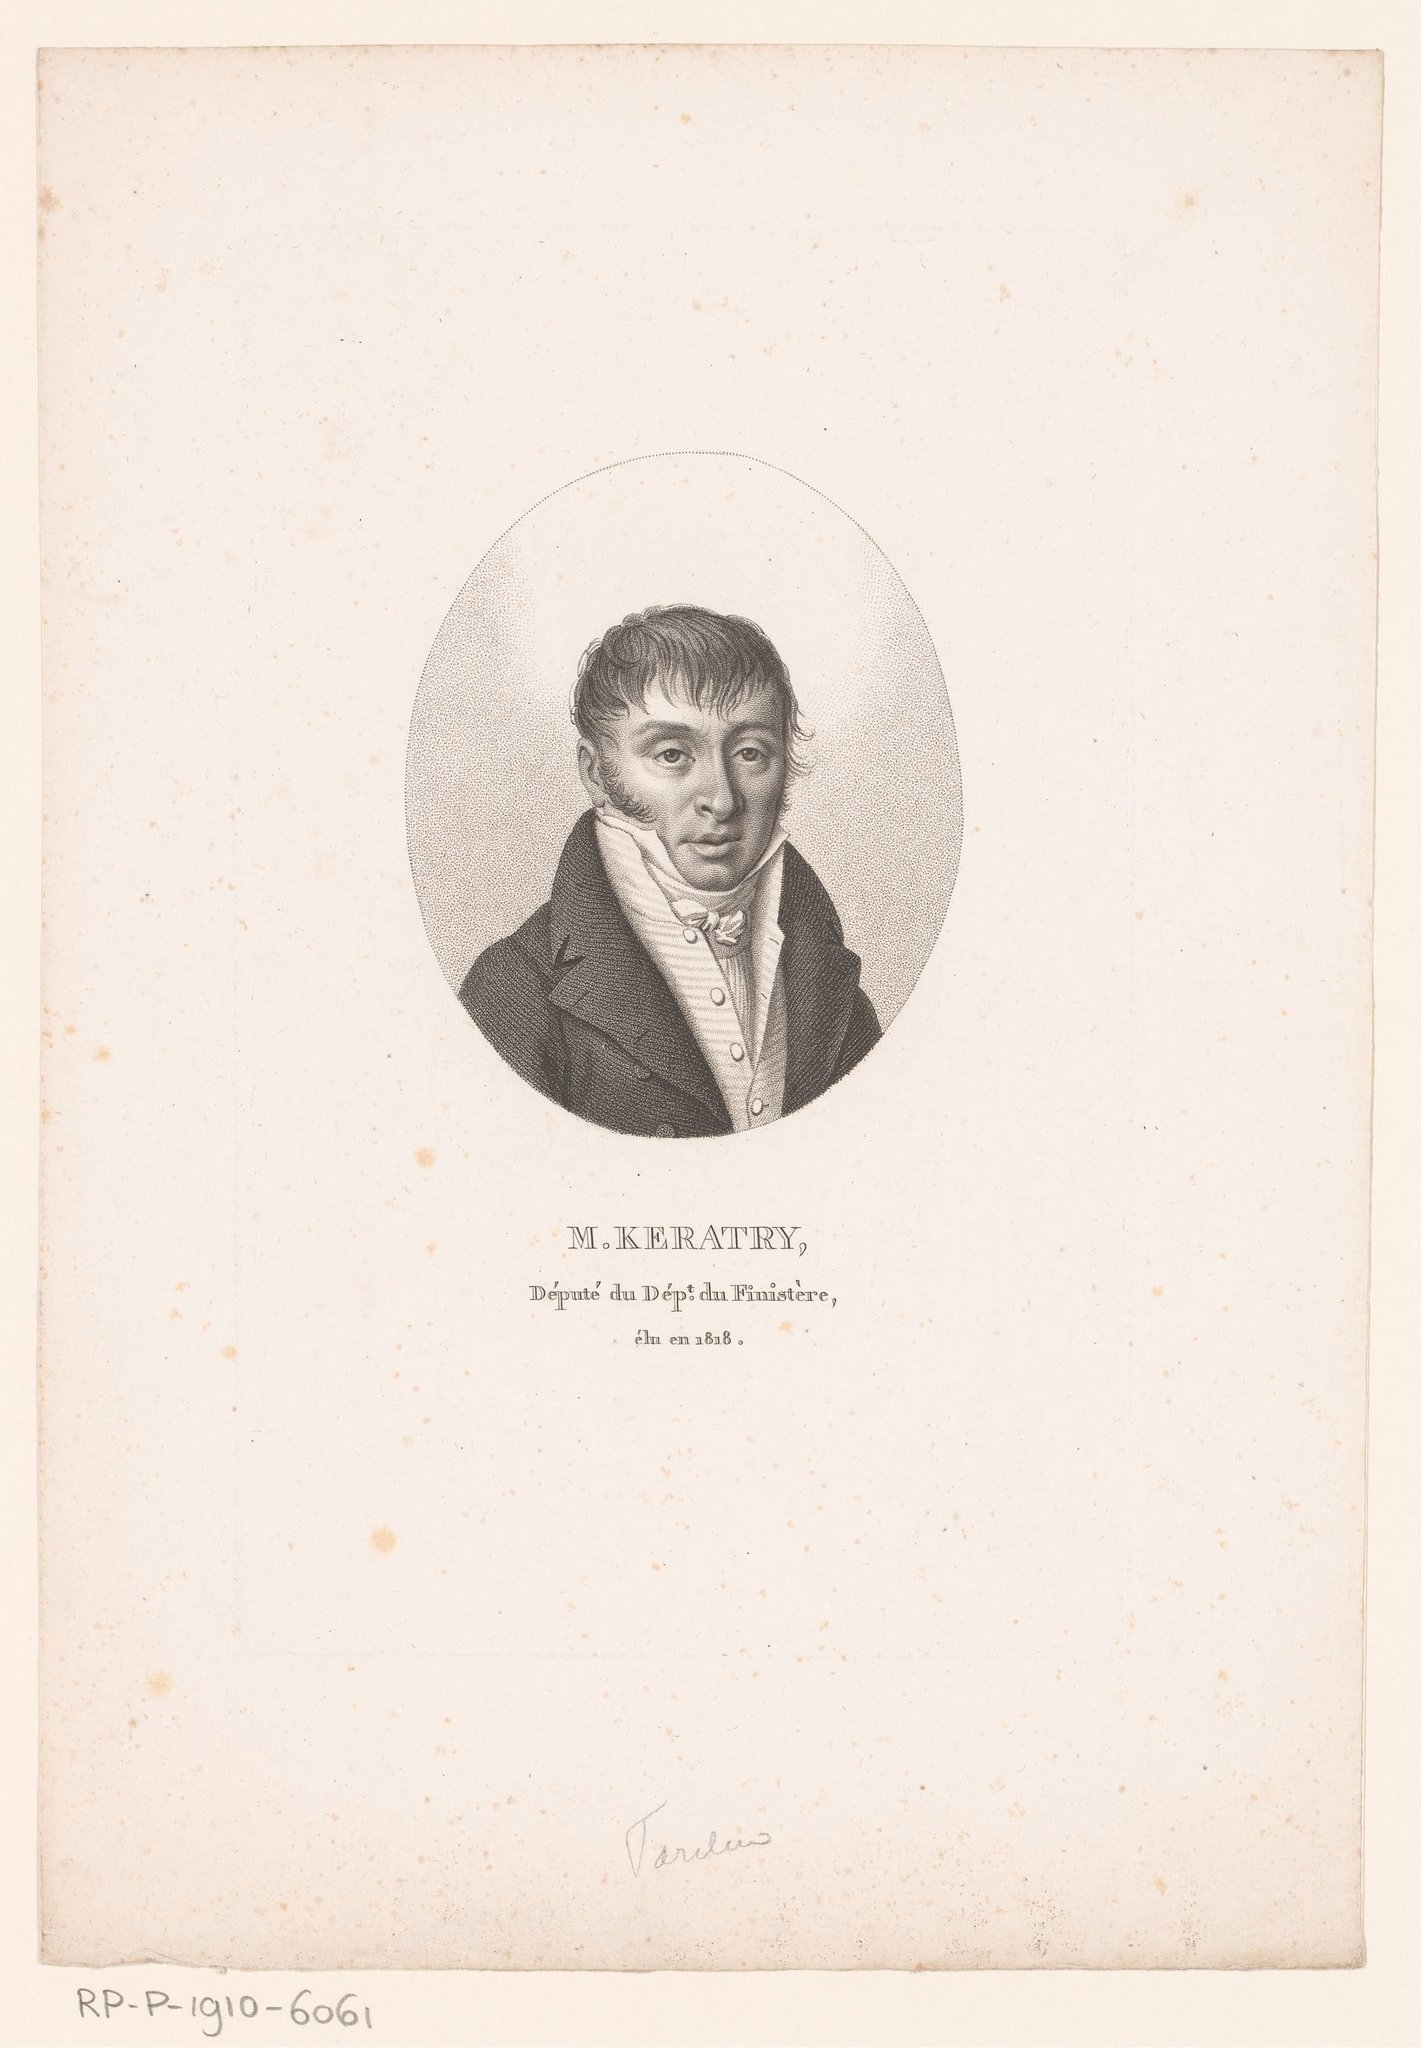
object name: book illustration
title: Portret van Auguste Hilarion, graaf van Kératry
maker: ambroise tardieu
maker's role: print maker, printer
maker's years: 1788-1841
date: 1820-1821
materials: paper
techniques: engraving, roulette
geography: paris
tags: politician, historical persons, politician, e.g. party leader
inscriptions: collector's mark: Lugt 2228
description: Prent uit: Tardieu, Ambroise. Portraits des députés, écrivains et pairs constitutionnels, défenseurs invariables de la charte et de la loi des élections du 5 février 1817. Parijs: Tardieu, Ambroise, 1820-1821.